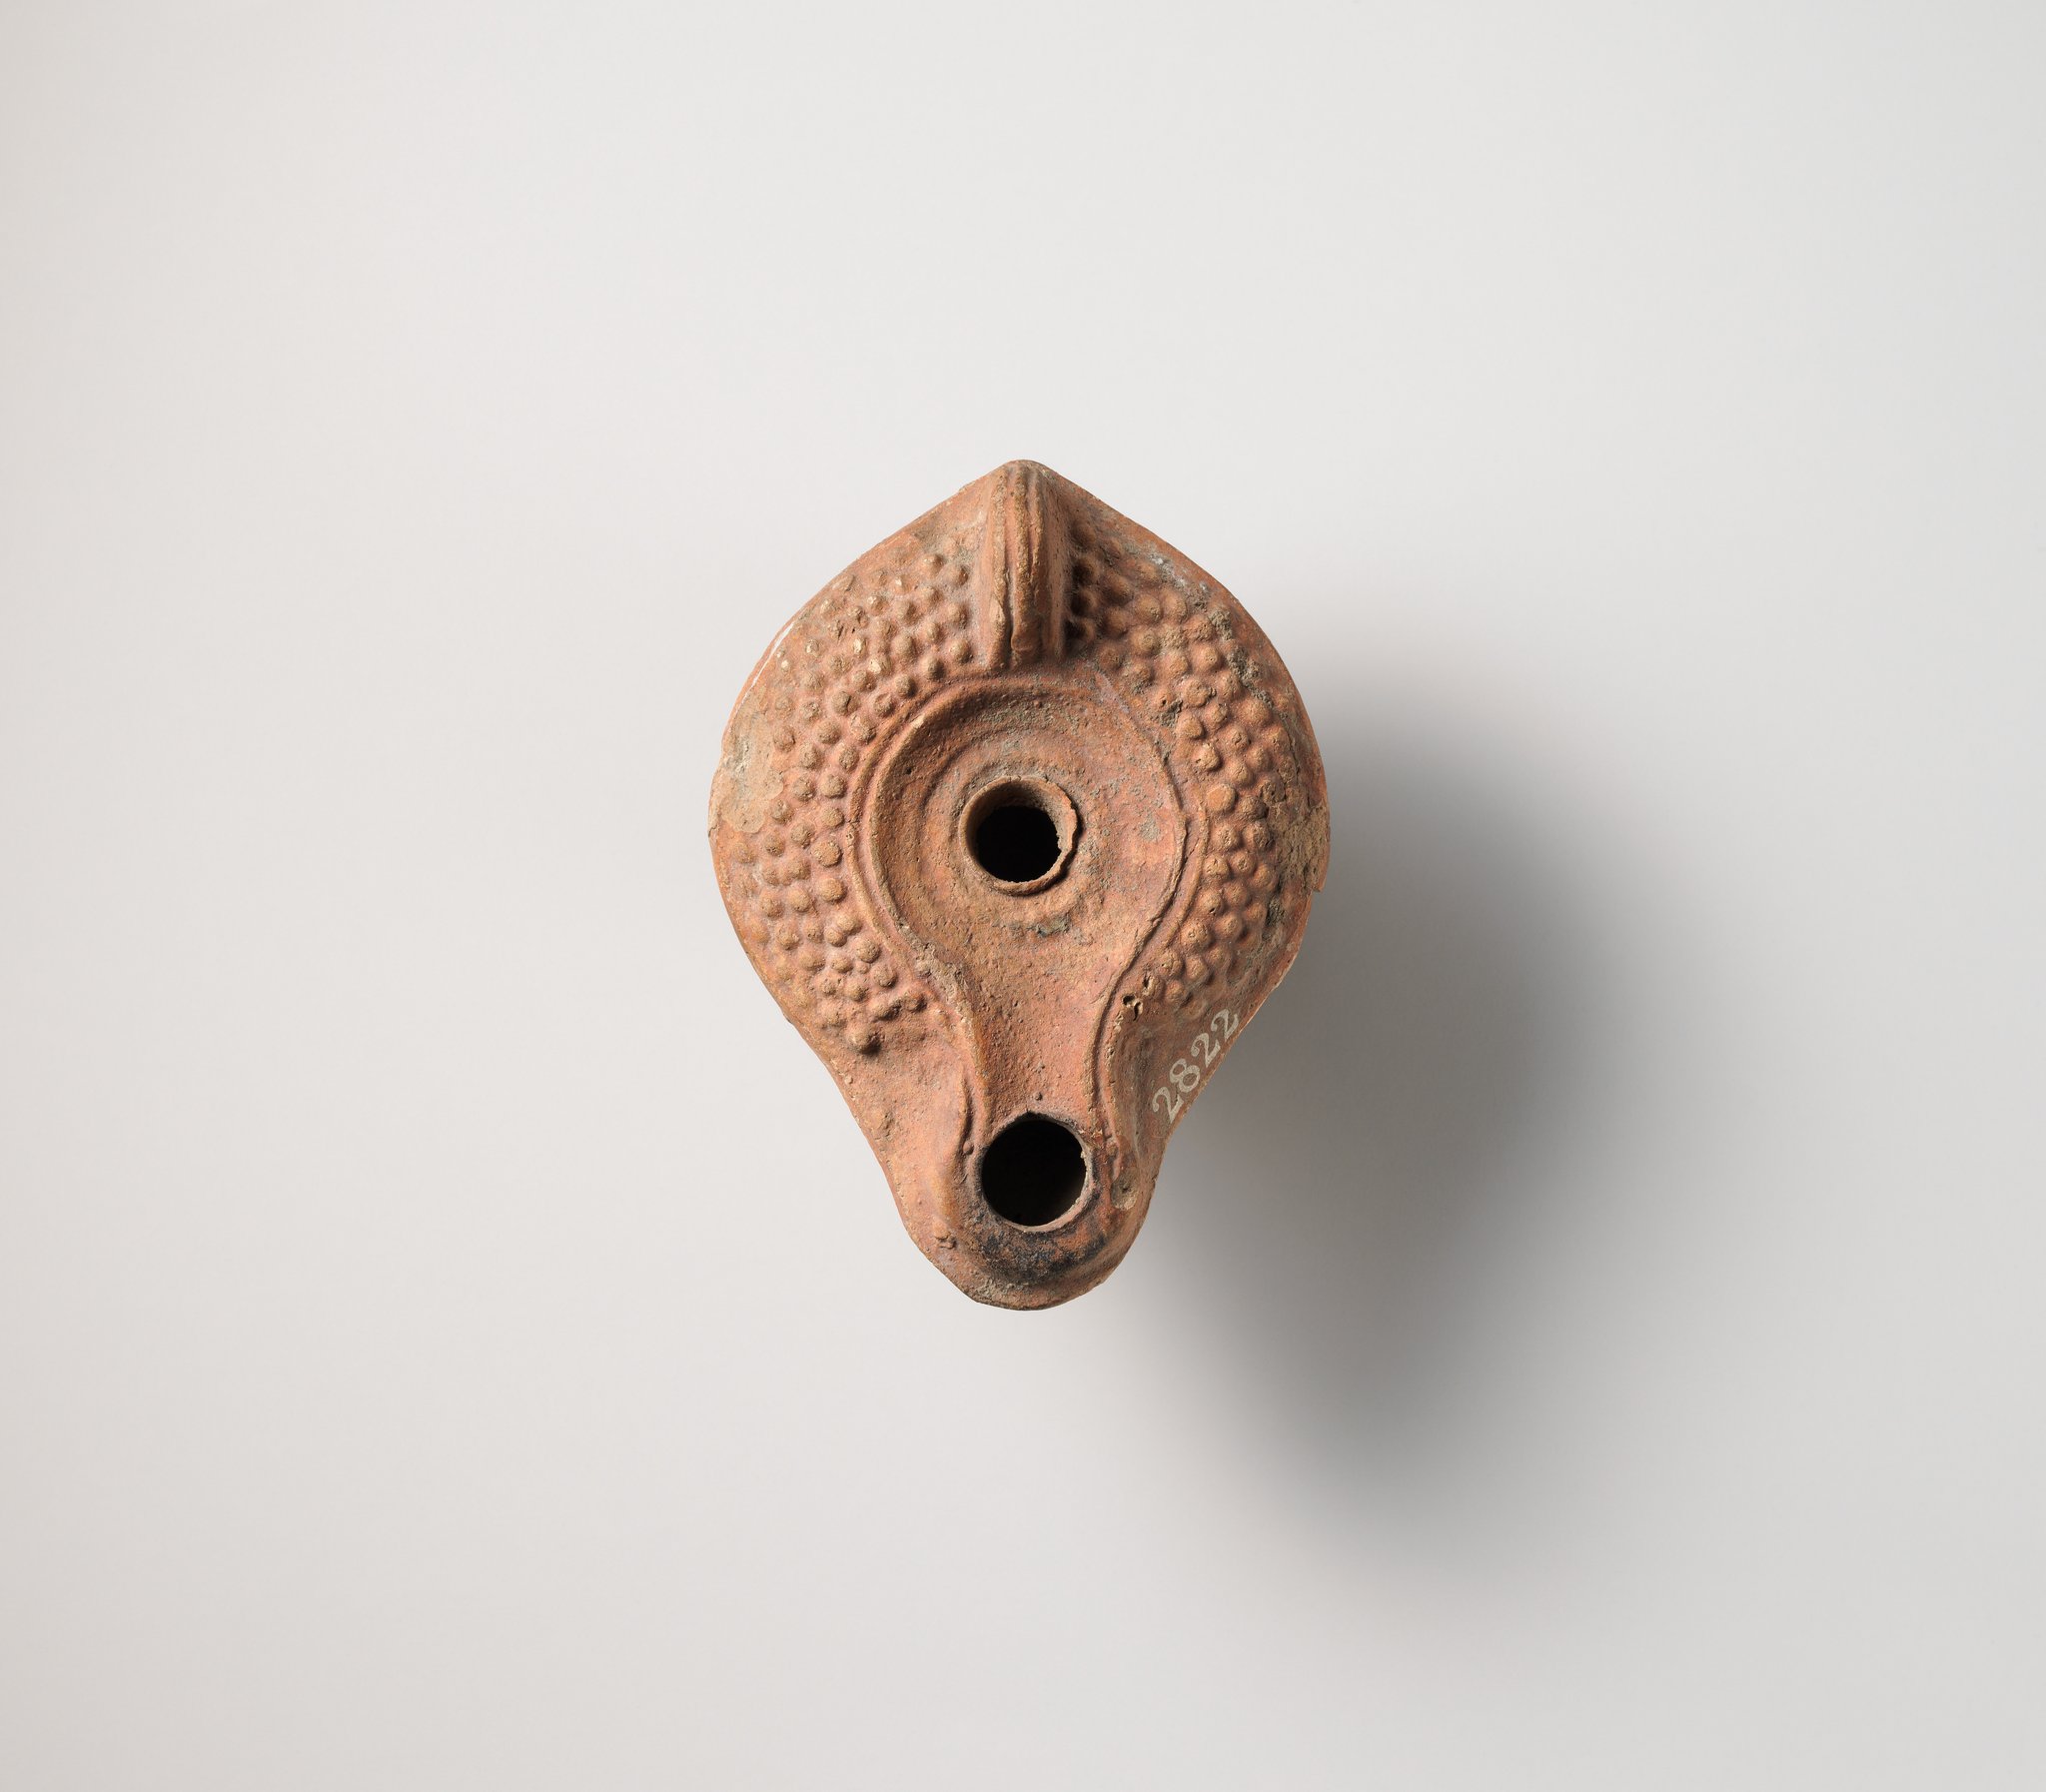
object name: lamp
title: Terracotta oil lamp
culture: roman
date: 201-300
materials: terracotta